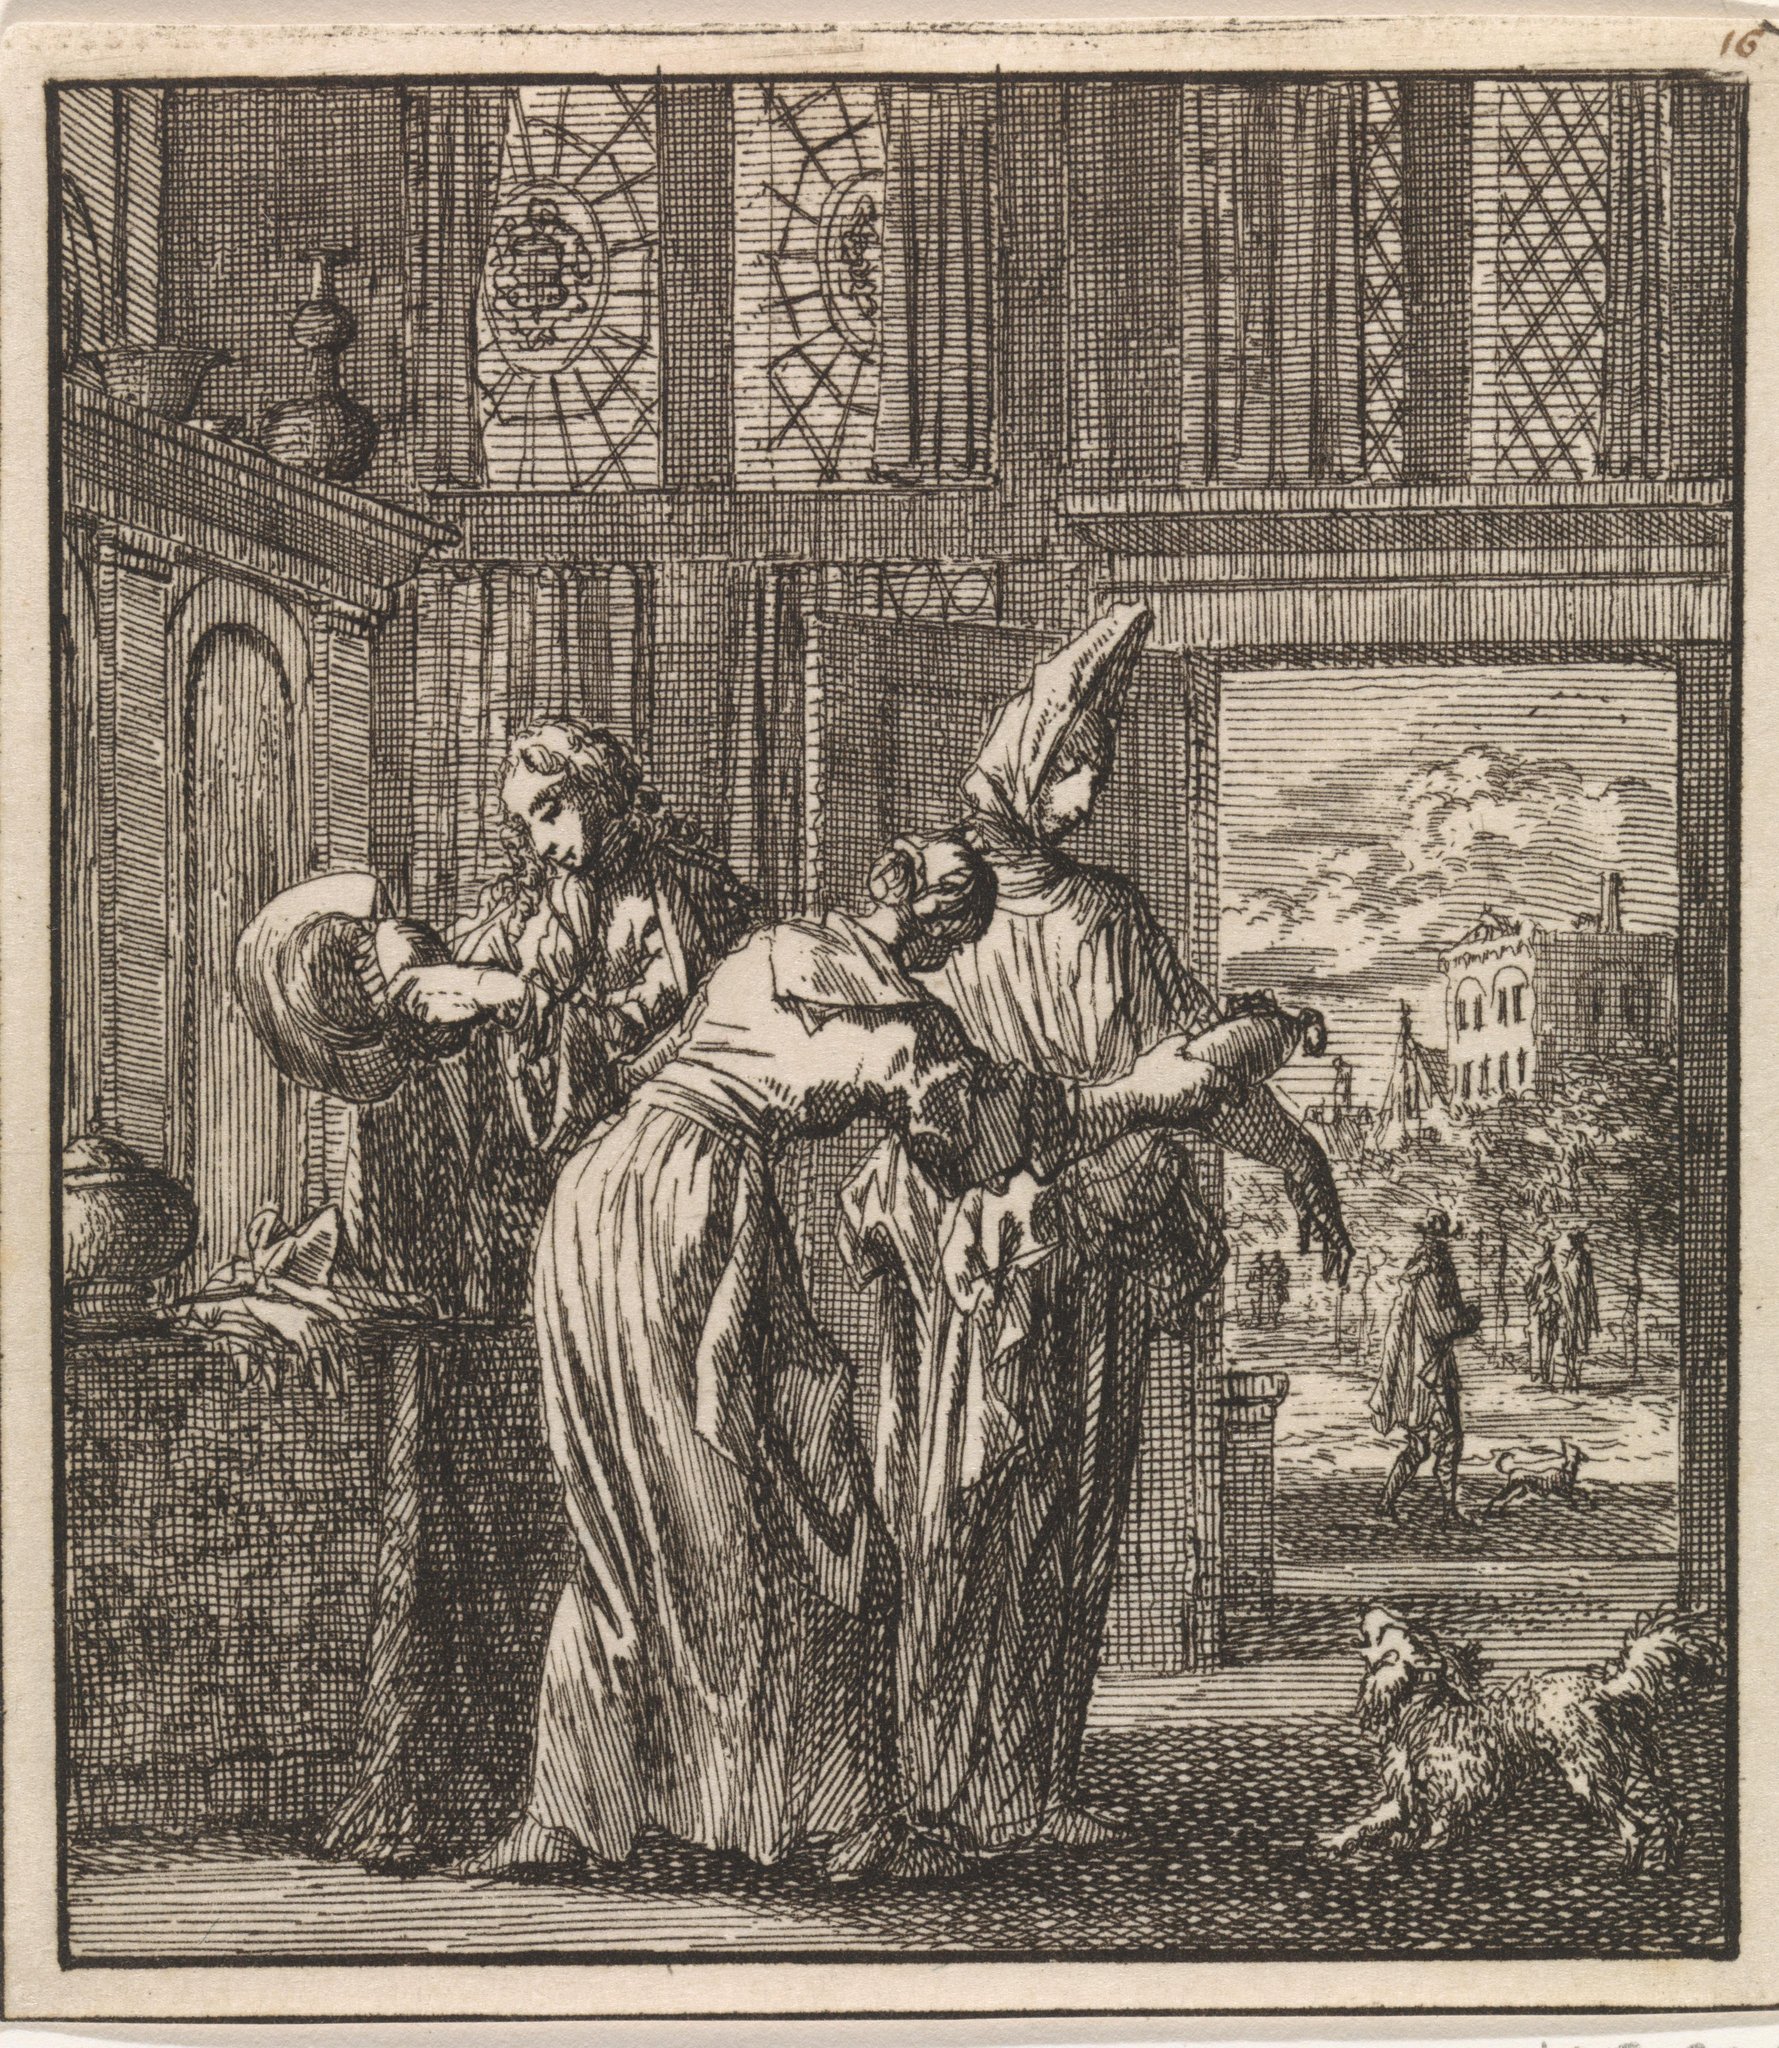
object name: print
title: Paar maakt zich klaar om uit wandelen te gaan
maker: jan luyken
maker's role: draughtsman, print maker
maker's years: 1649-1712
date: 1711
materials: paper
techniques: etching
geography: amsterdam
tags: preparations ~ travelling, dog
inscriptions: collector's mark: Lugt 2228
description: Proefdruk van illustratie voor: Luyken, Jan. Het leerzaam huisraad, vertoond in vyftig konstige figuuren, met godlyke spreuken en stichtelyke verzen: Pieter Arentsz. II (wed.) en Cornelis van der Sys, 1711, p. 58.